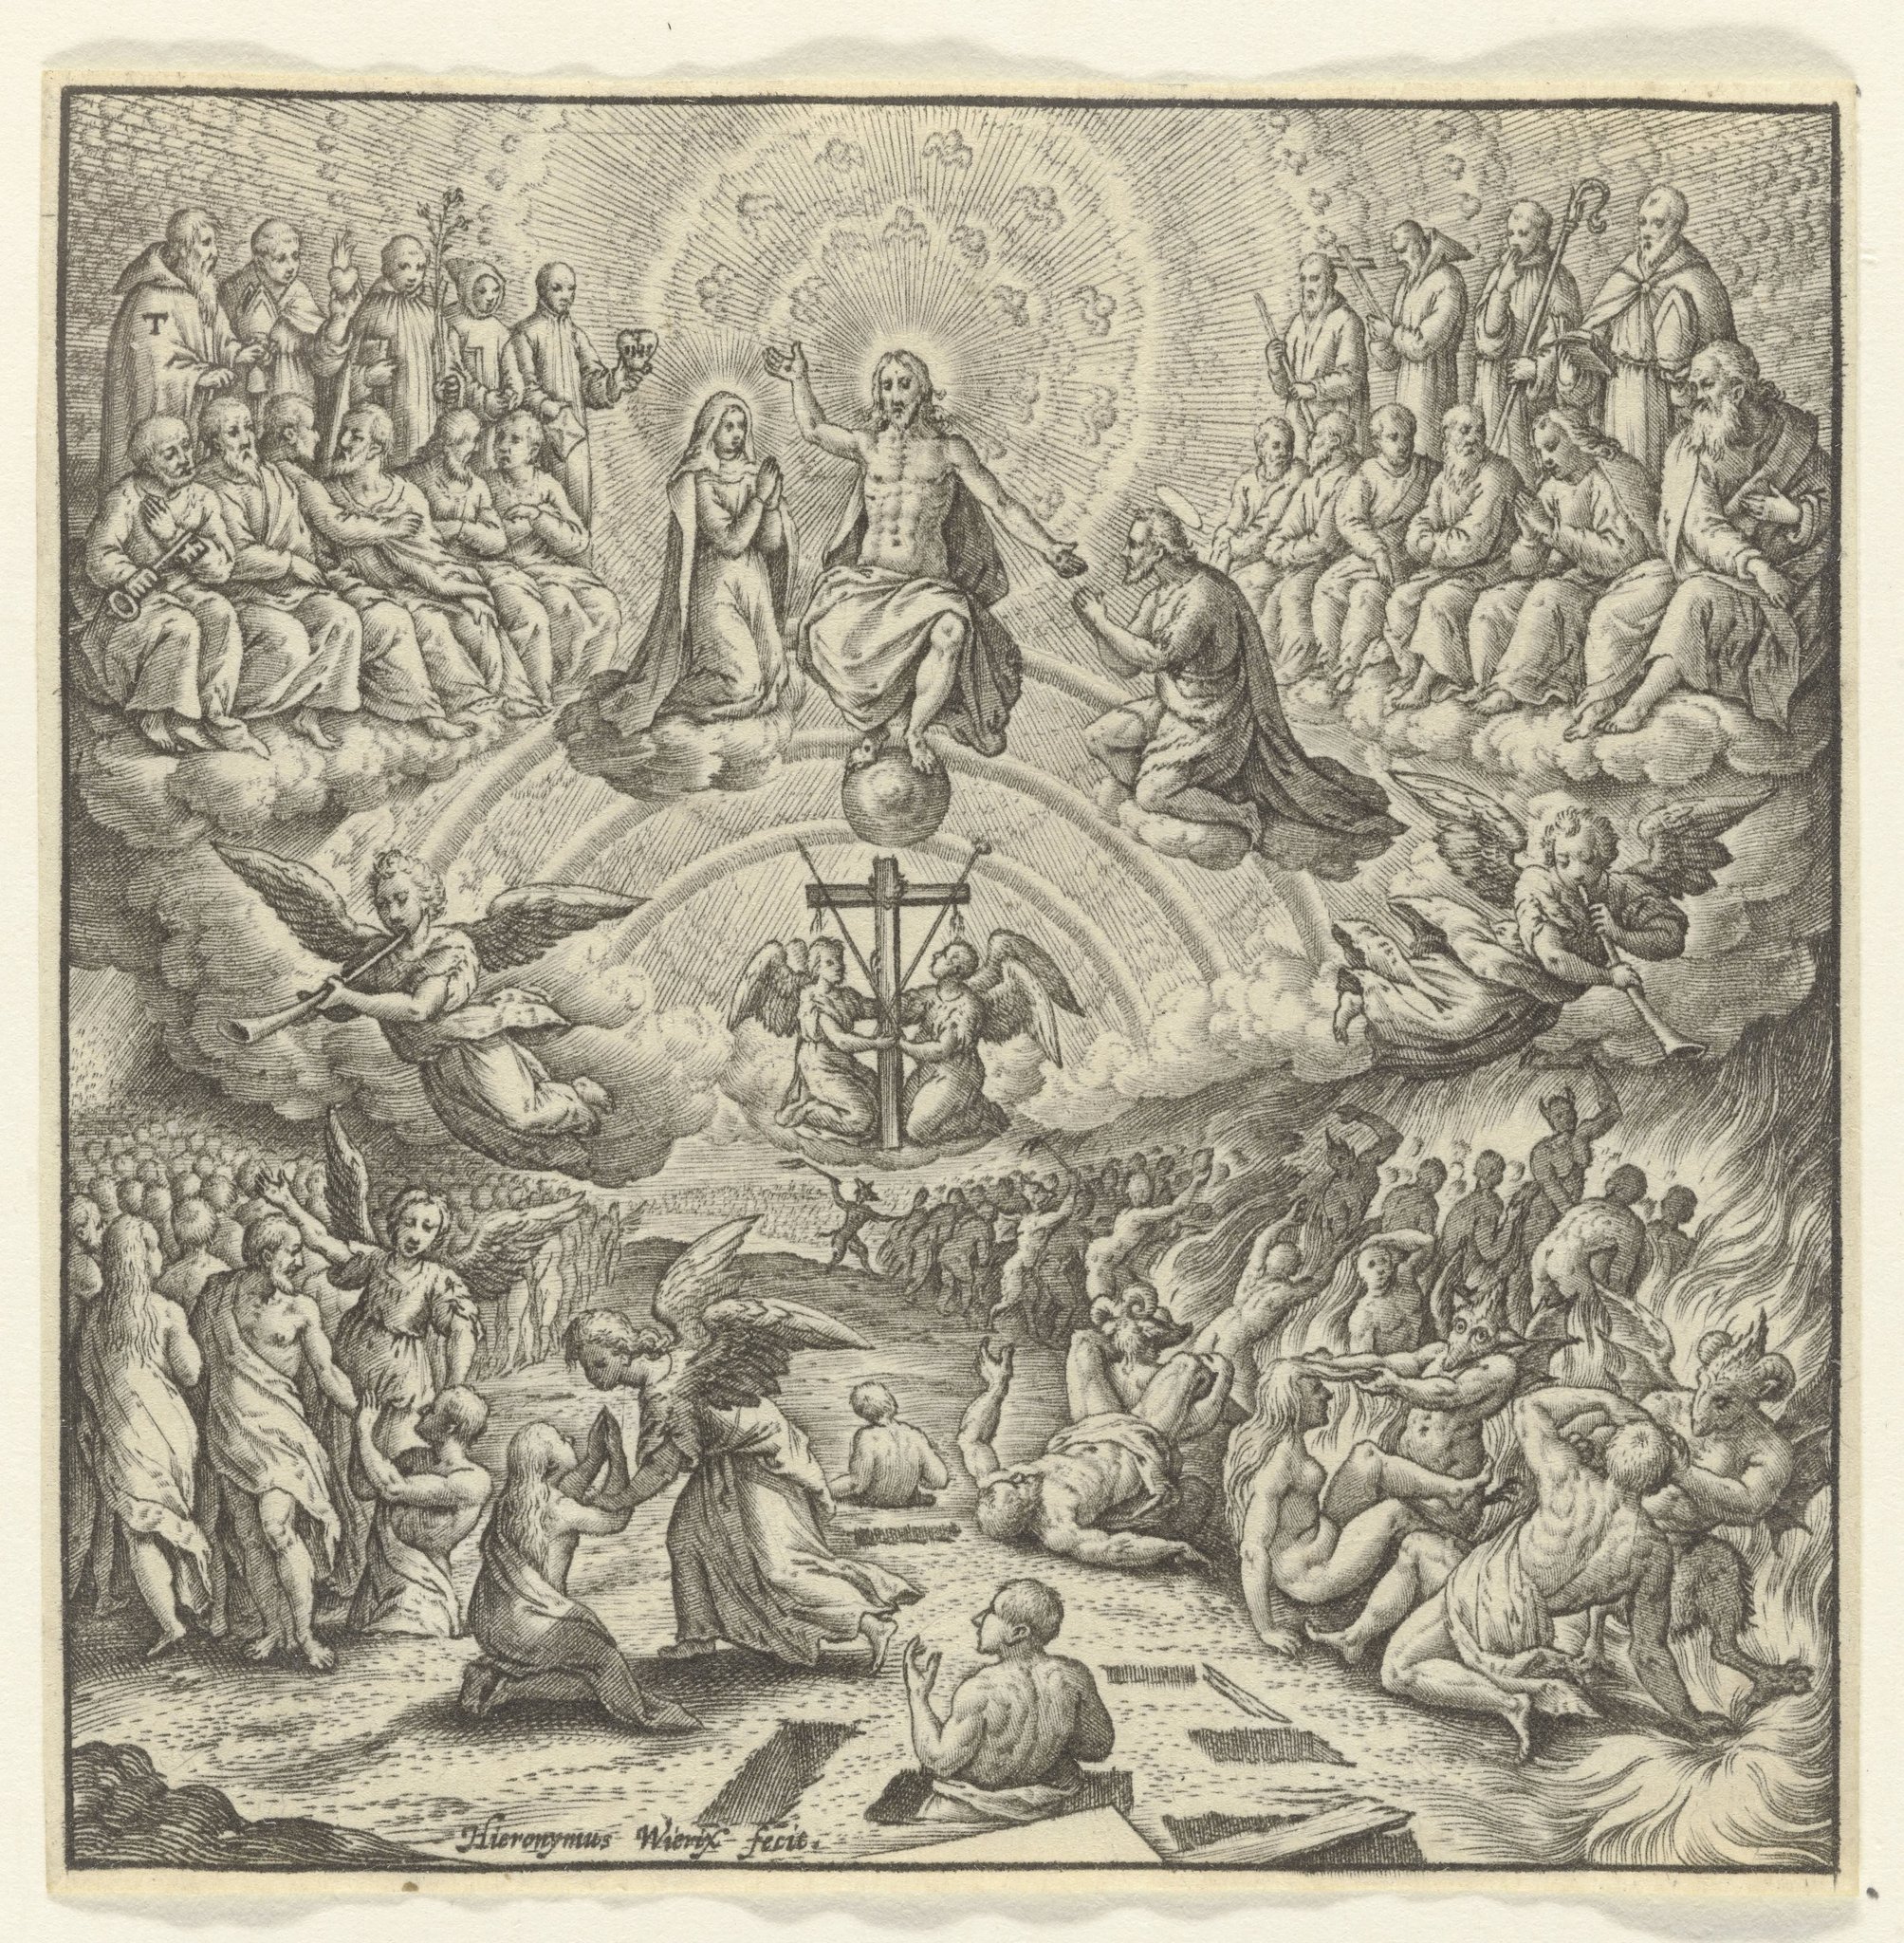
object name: print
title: Laatste Oordeel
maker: hieronymus wierix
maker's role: draughtsman, print maker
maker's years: 1553-1619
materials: paper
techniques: engraving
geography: antwerp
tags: comprehensive representation of last judgement: christ (with sword and lily), often surrounded by elders and sometimes accompanied by mary and john the baptist, appears in the sky with trumpeting angels (and sometimes angels holding the instruments of the passion); after the resurrection of the dead the blessed are led to heaven by angels, and the damned are dragged into hell by devils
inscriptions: signature: ‘Hieronymus Wierix fecit’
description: Christus zit als rechter op de regenboog, zijn voeten rustend op de wereldbol. Hij wordt omgeven door cherubijnen, heiligen en apostelen. Op aarde staan de mensen op uit hun graf. Hun zielen worden verdeeld onder de engelen en de duivels.